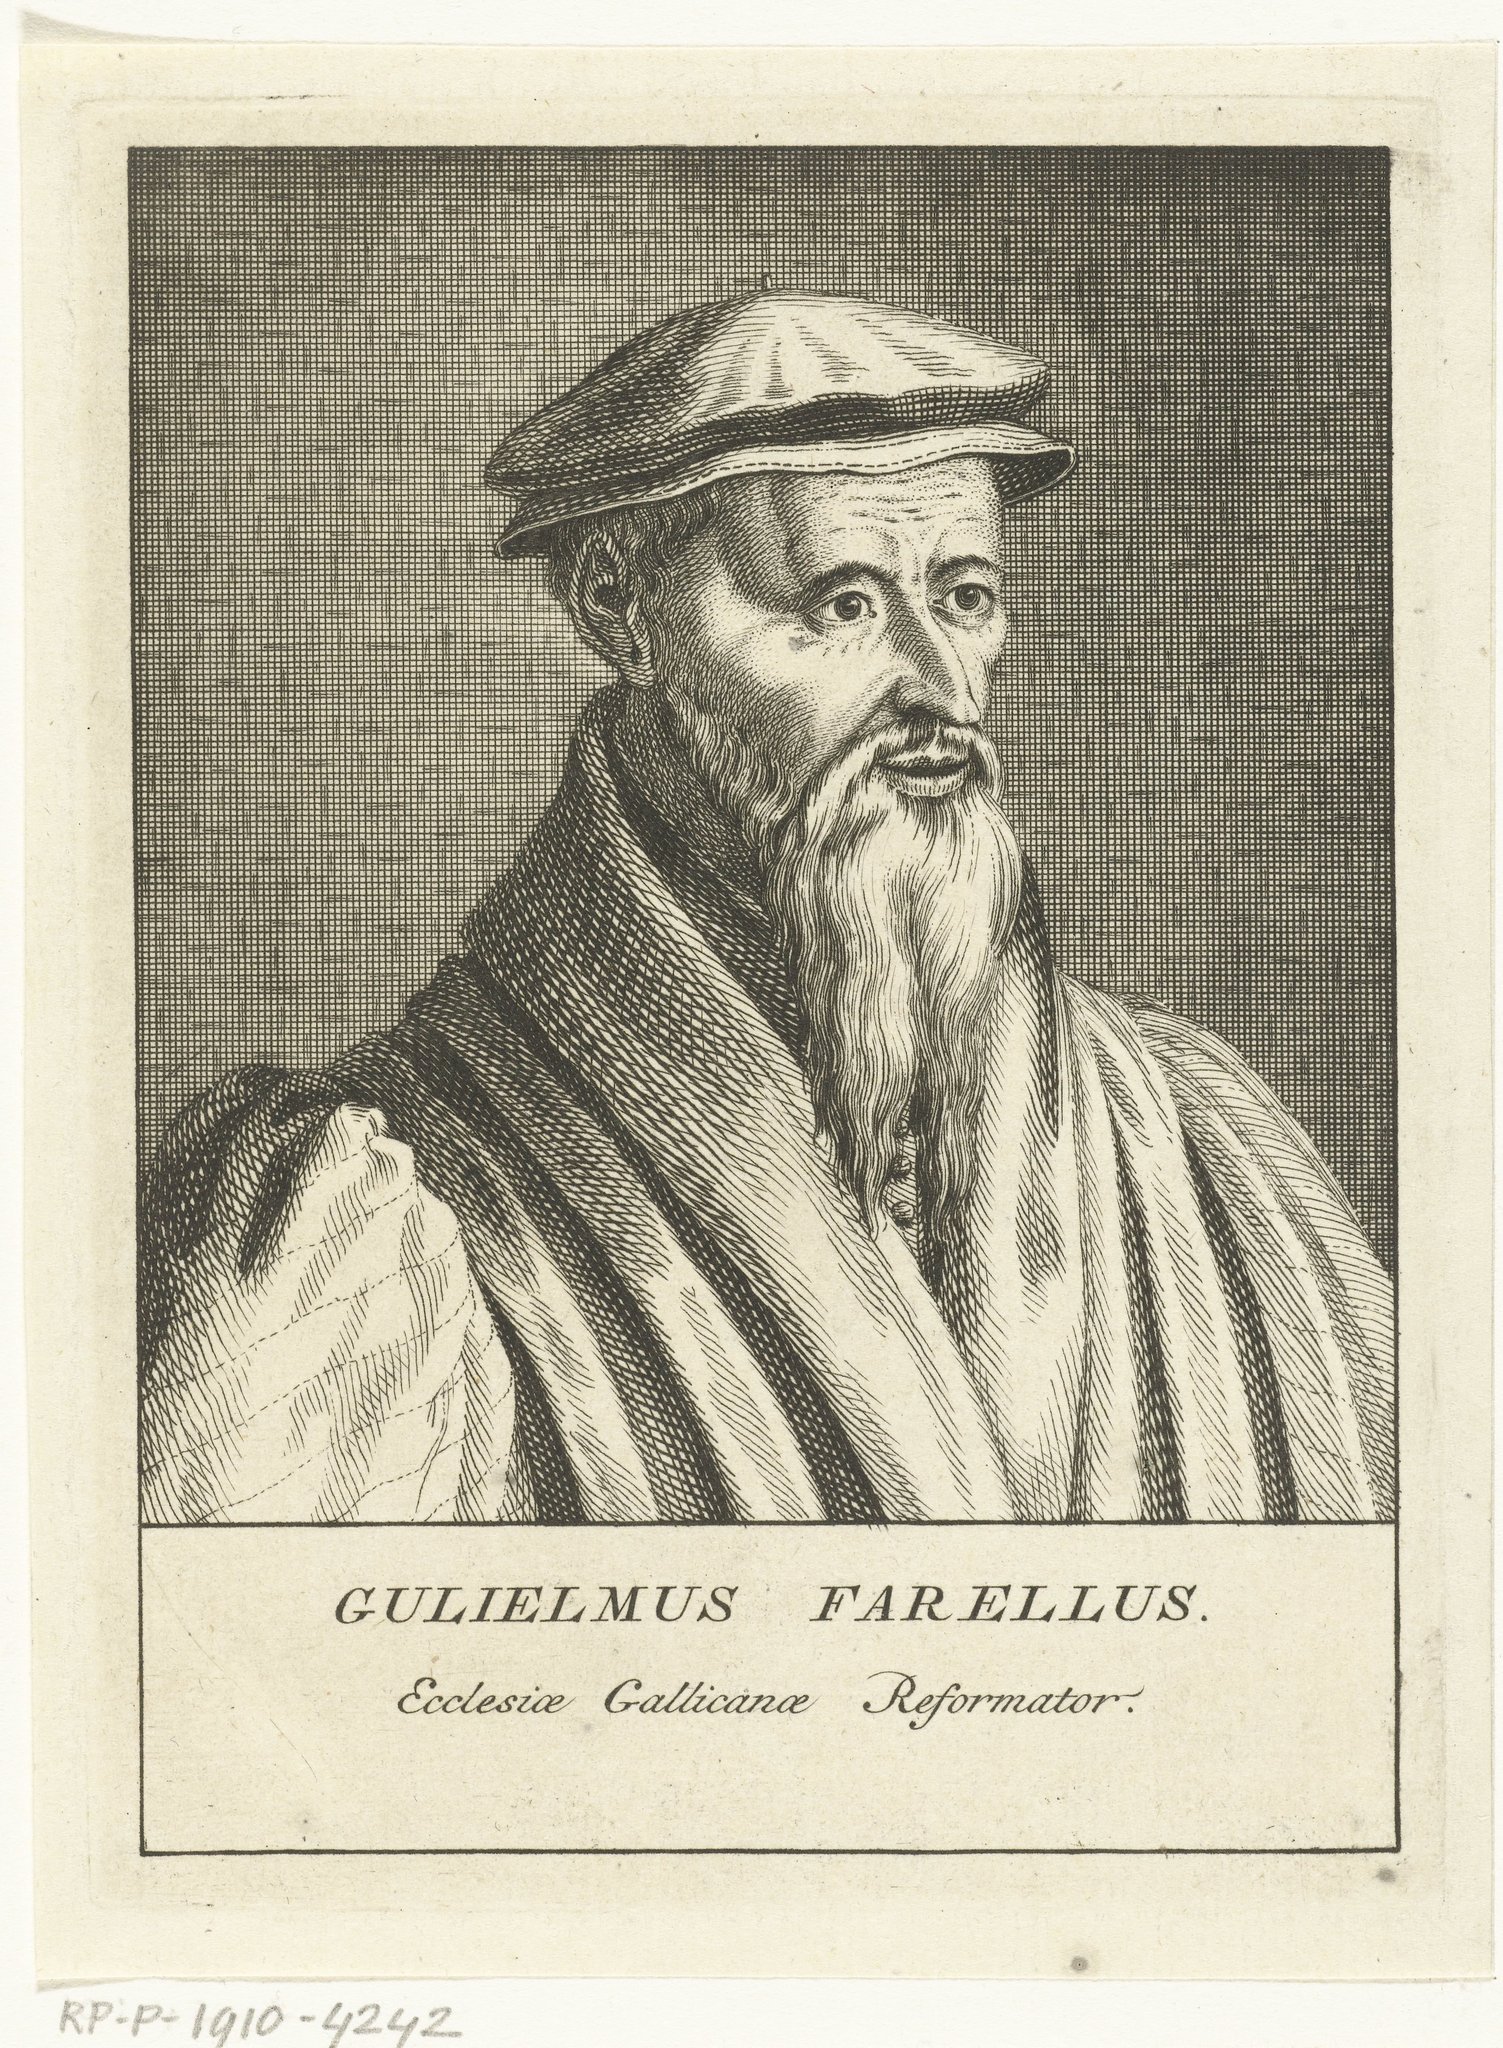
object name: print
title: Gulielmus Farellus Ecclesiae Gallicanae Reformator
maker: françois van bleyswijck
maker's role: draughtsman, print maker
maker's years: 1671-1746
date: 1681-1746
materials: paper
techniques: engraving, etching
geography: leiden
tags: gap, neuchâtel, hervormer, guillaume farel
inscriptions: collector's mark: Lugt 2228